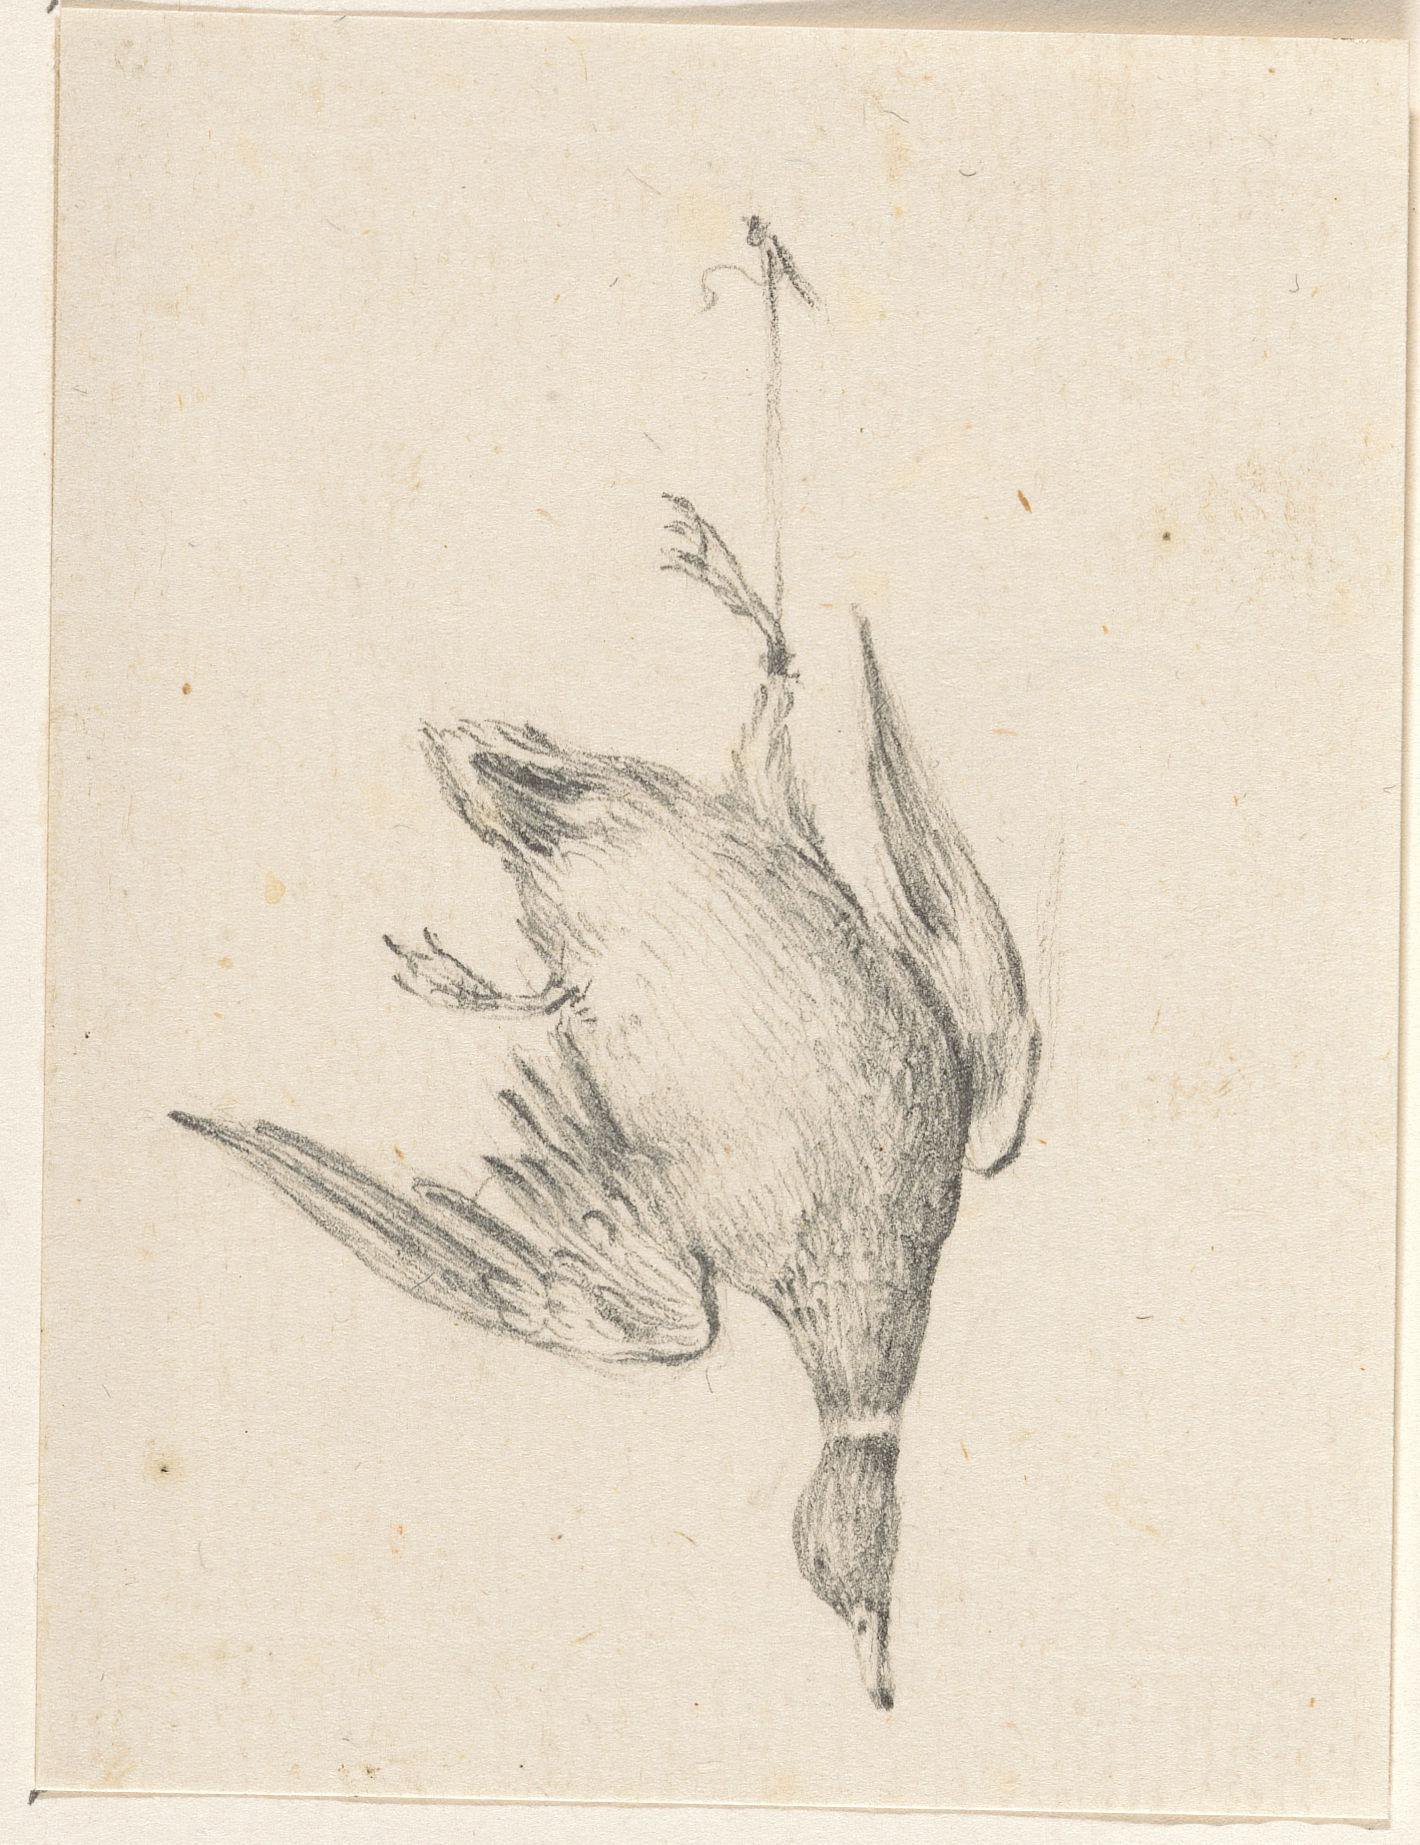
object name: drawing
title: Eend, hangend aan een touw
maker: jean bernard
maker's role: draughtsman, print maker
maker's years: 1765-1833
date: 1775-1833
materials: chalk, paper, pencil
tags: ducks (domestic waterbirds), water-birds: duck